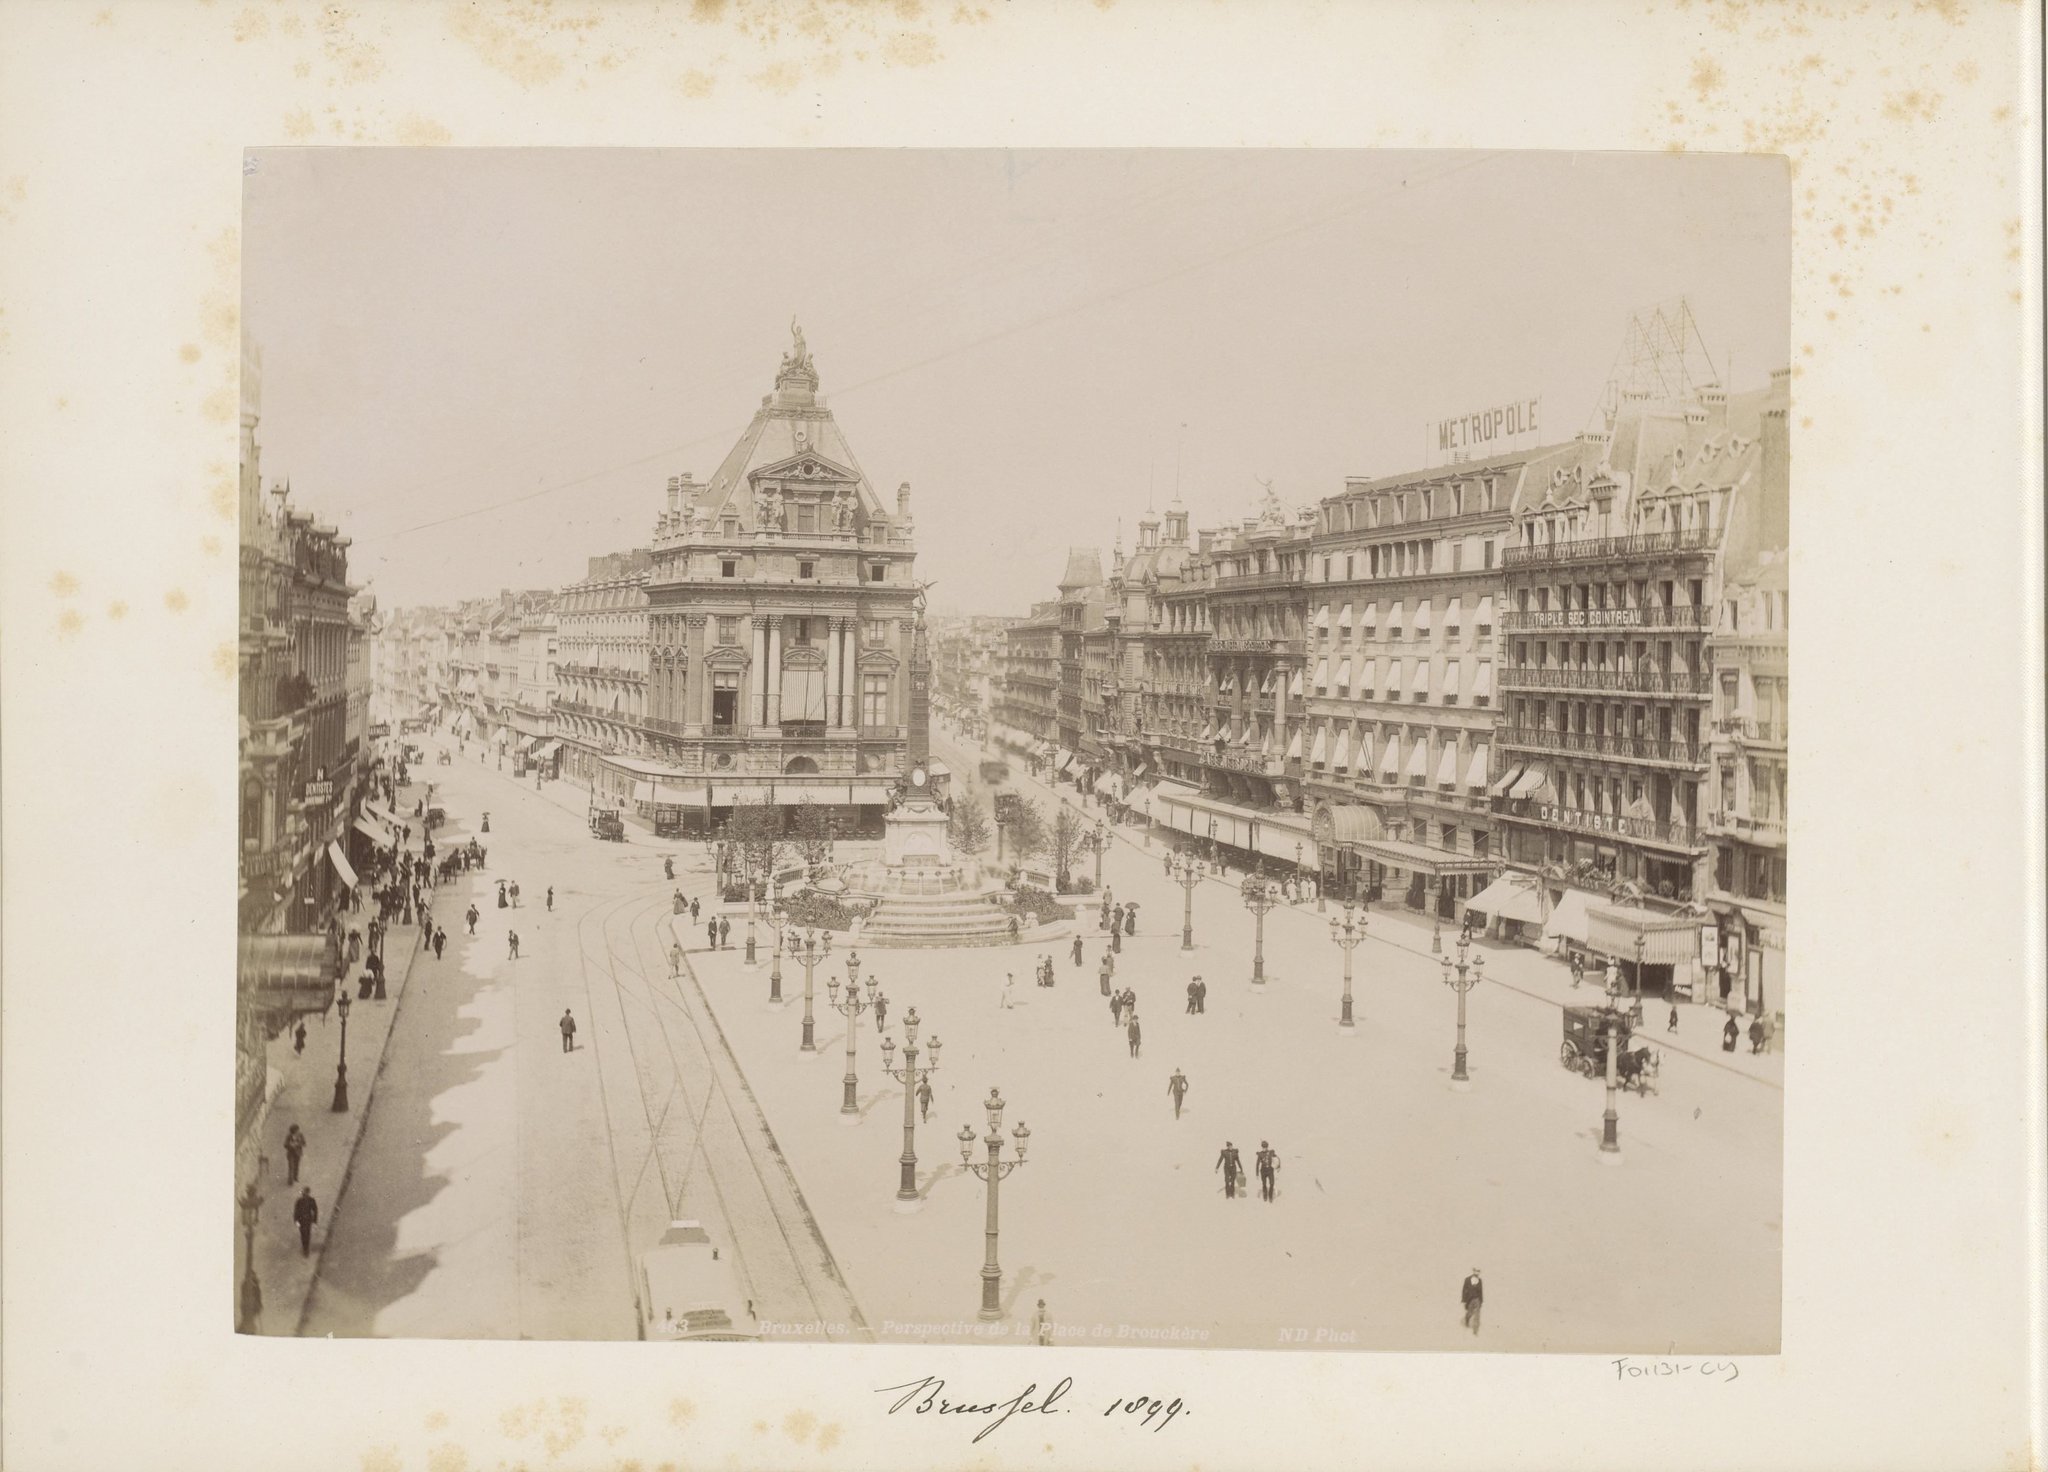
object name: album leaf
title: Gezicht op de noordzijde van het De Brouckèreplein in Brussel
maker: étienne neurdein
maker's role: publisher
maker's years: 1832-1918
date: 1880-1899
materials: paper, photographic support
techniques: albumen print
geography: brussels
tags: square, place, circus, etc. (+ city(-scape) with figures, staffage), brussels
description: Onderdeel van Reisalbum met bezienswaardigheden in Duitsland, Oostenrijk, Zwitserland, Luxemburg en België.